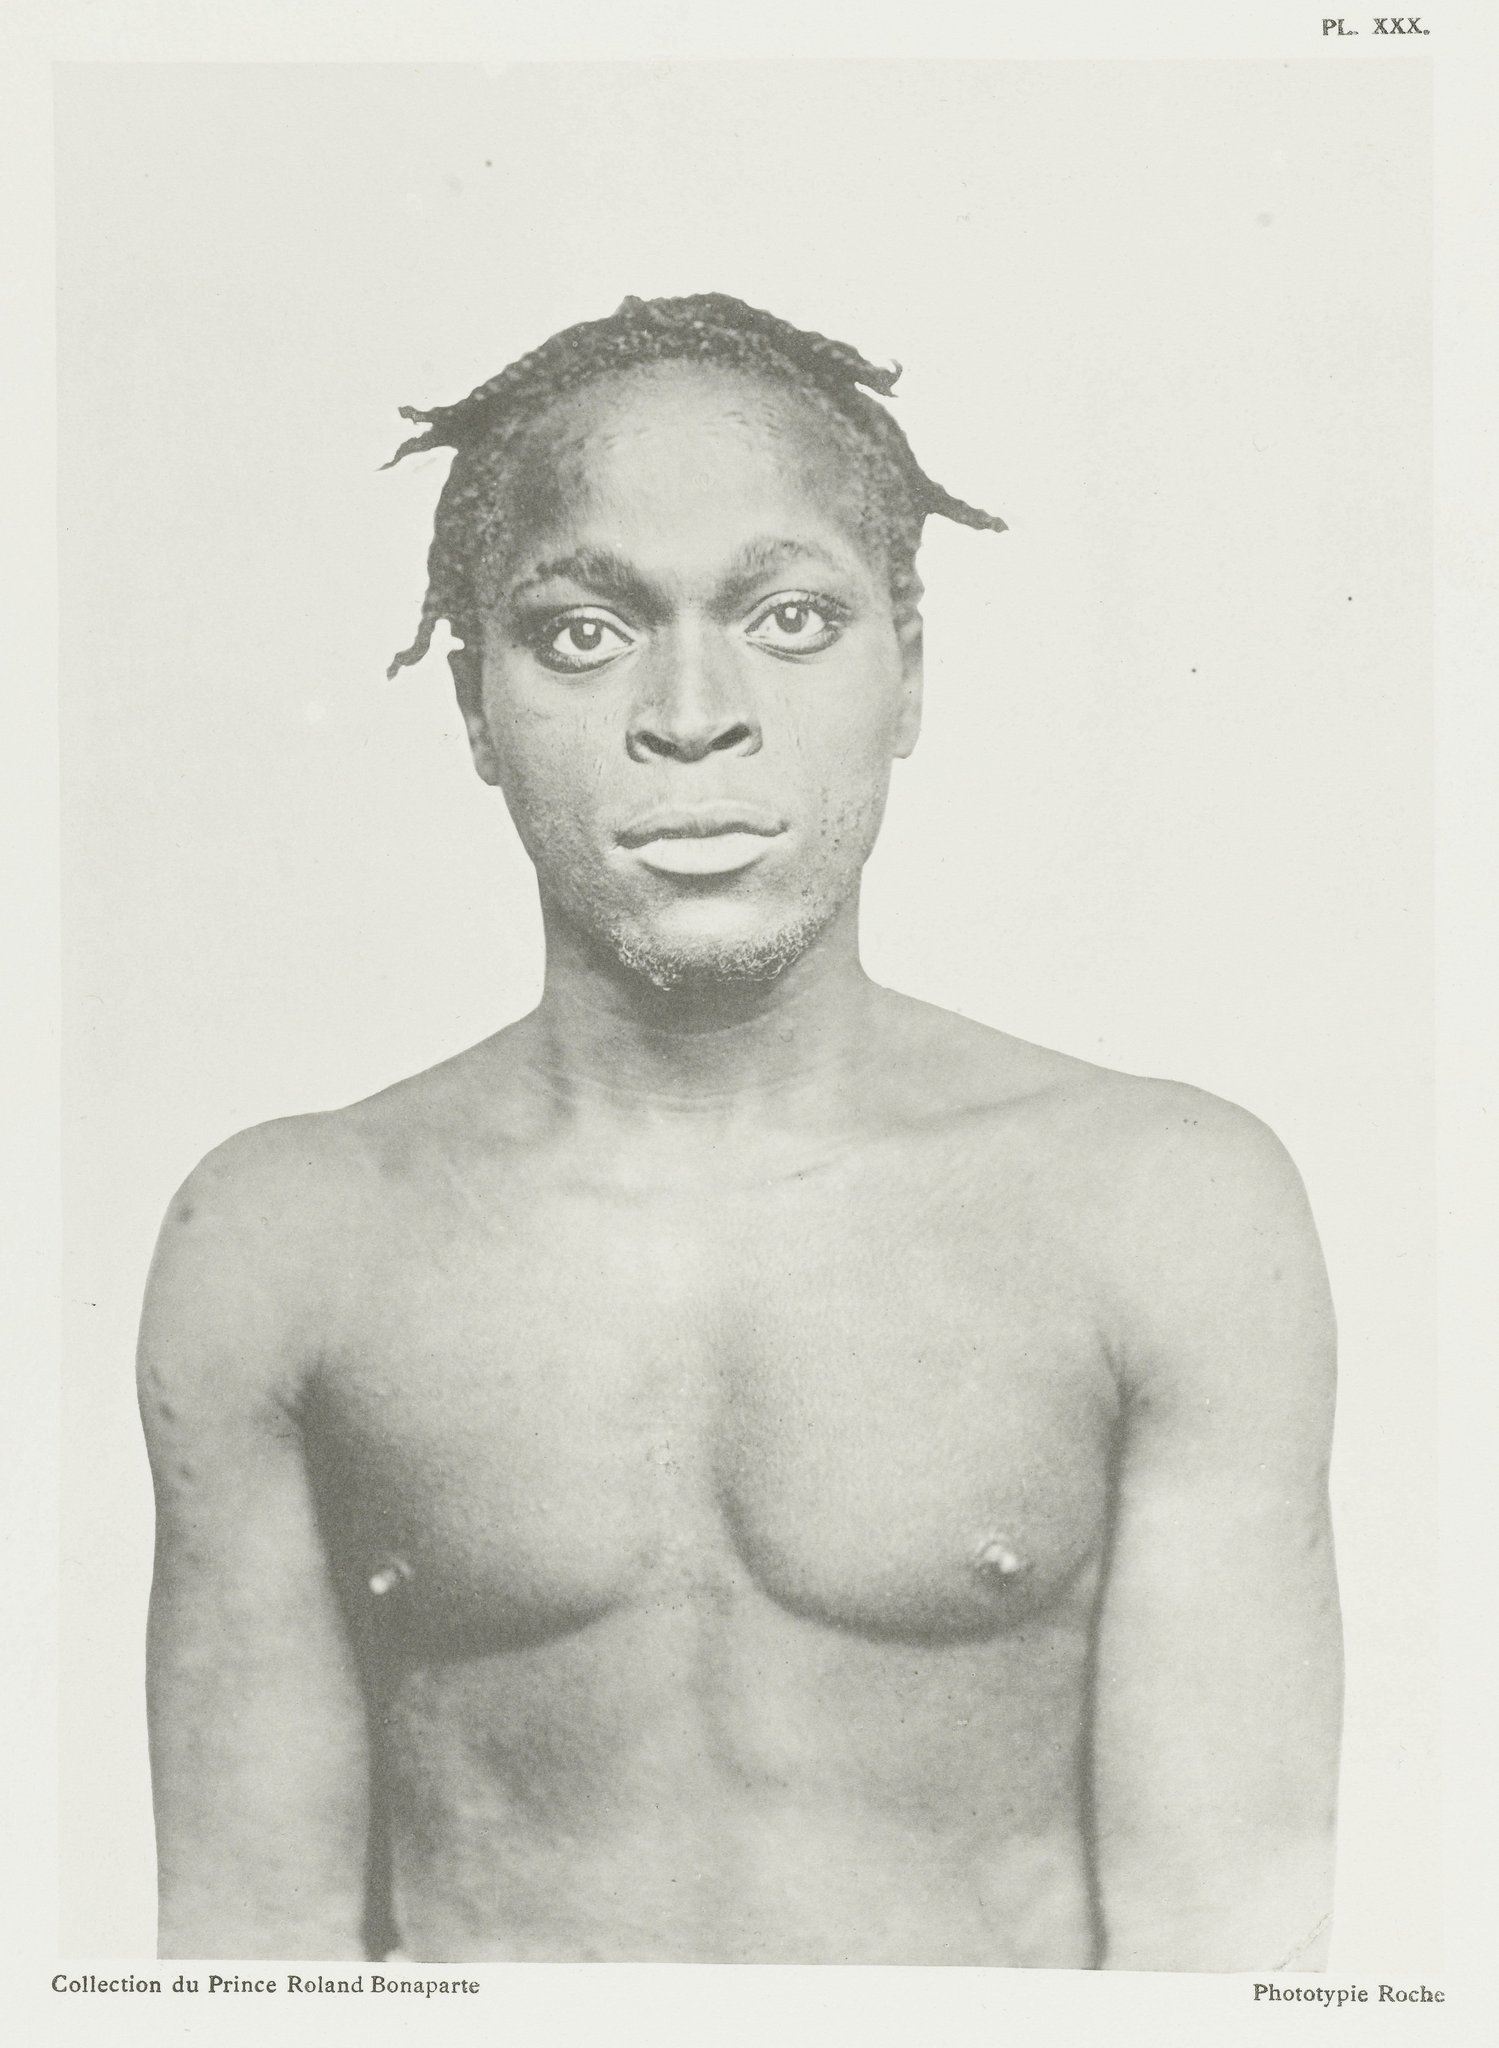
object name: page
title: Portret van Kwamina Baja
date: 1883-1884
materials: paper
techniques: photograph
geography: amsterdam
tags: adult man, historical persons, amsterdam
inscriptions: inscription: ‘Collection du Prince Roland Bonaparte/ Phototypie Roche’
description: Portret van Kwamina Baja, een Saramaccaner Marron uit Suriname, gefotografeerd op de Internationale Koloniale en Uitvoerhandel Tentoonstelling, Amsterdam 1883.